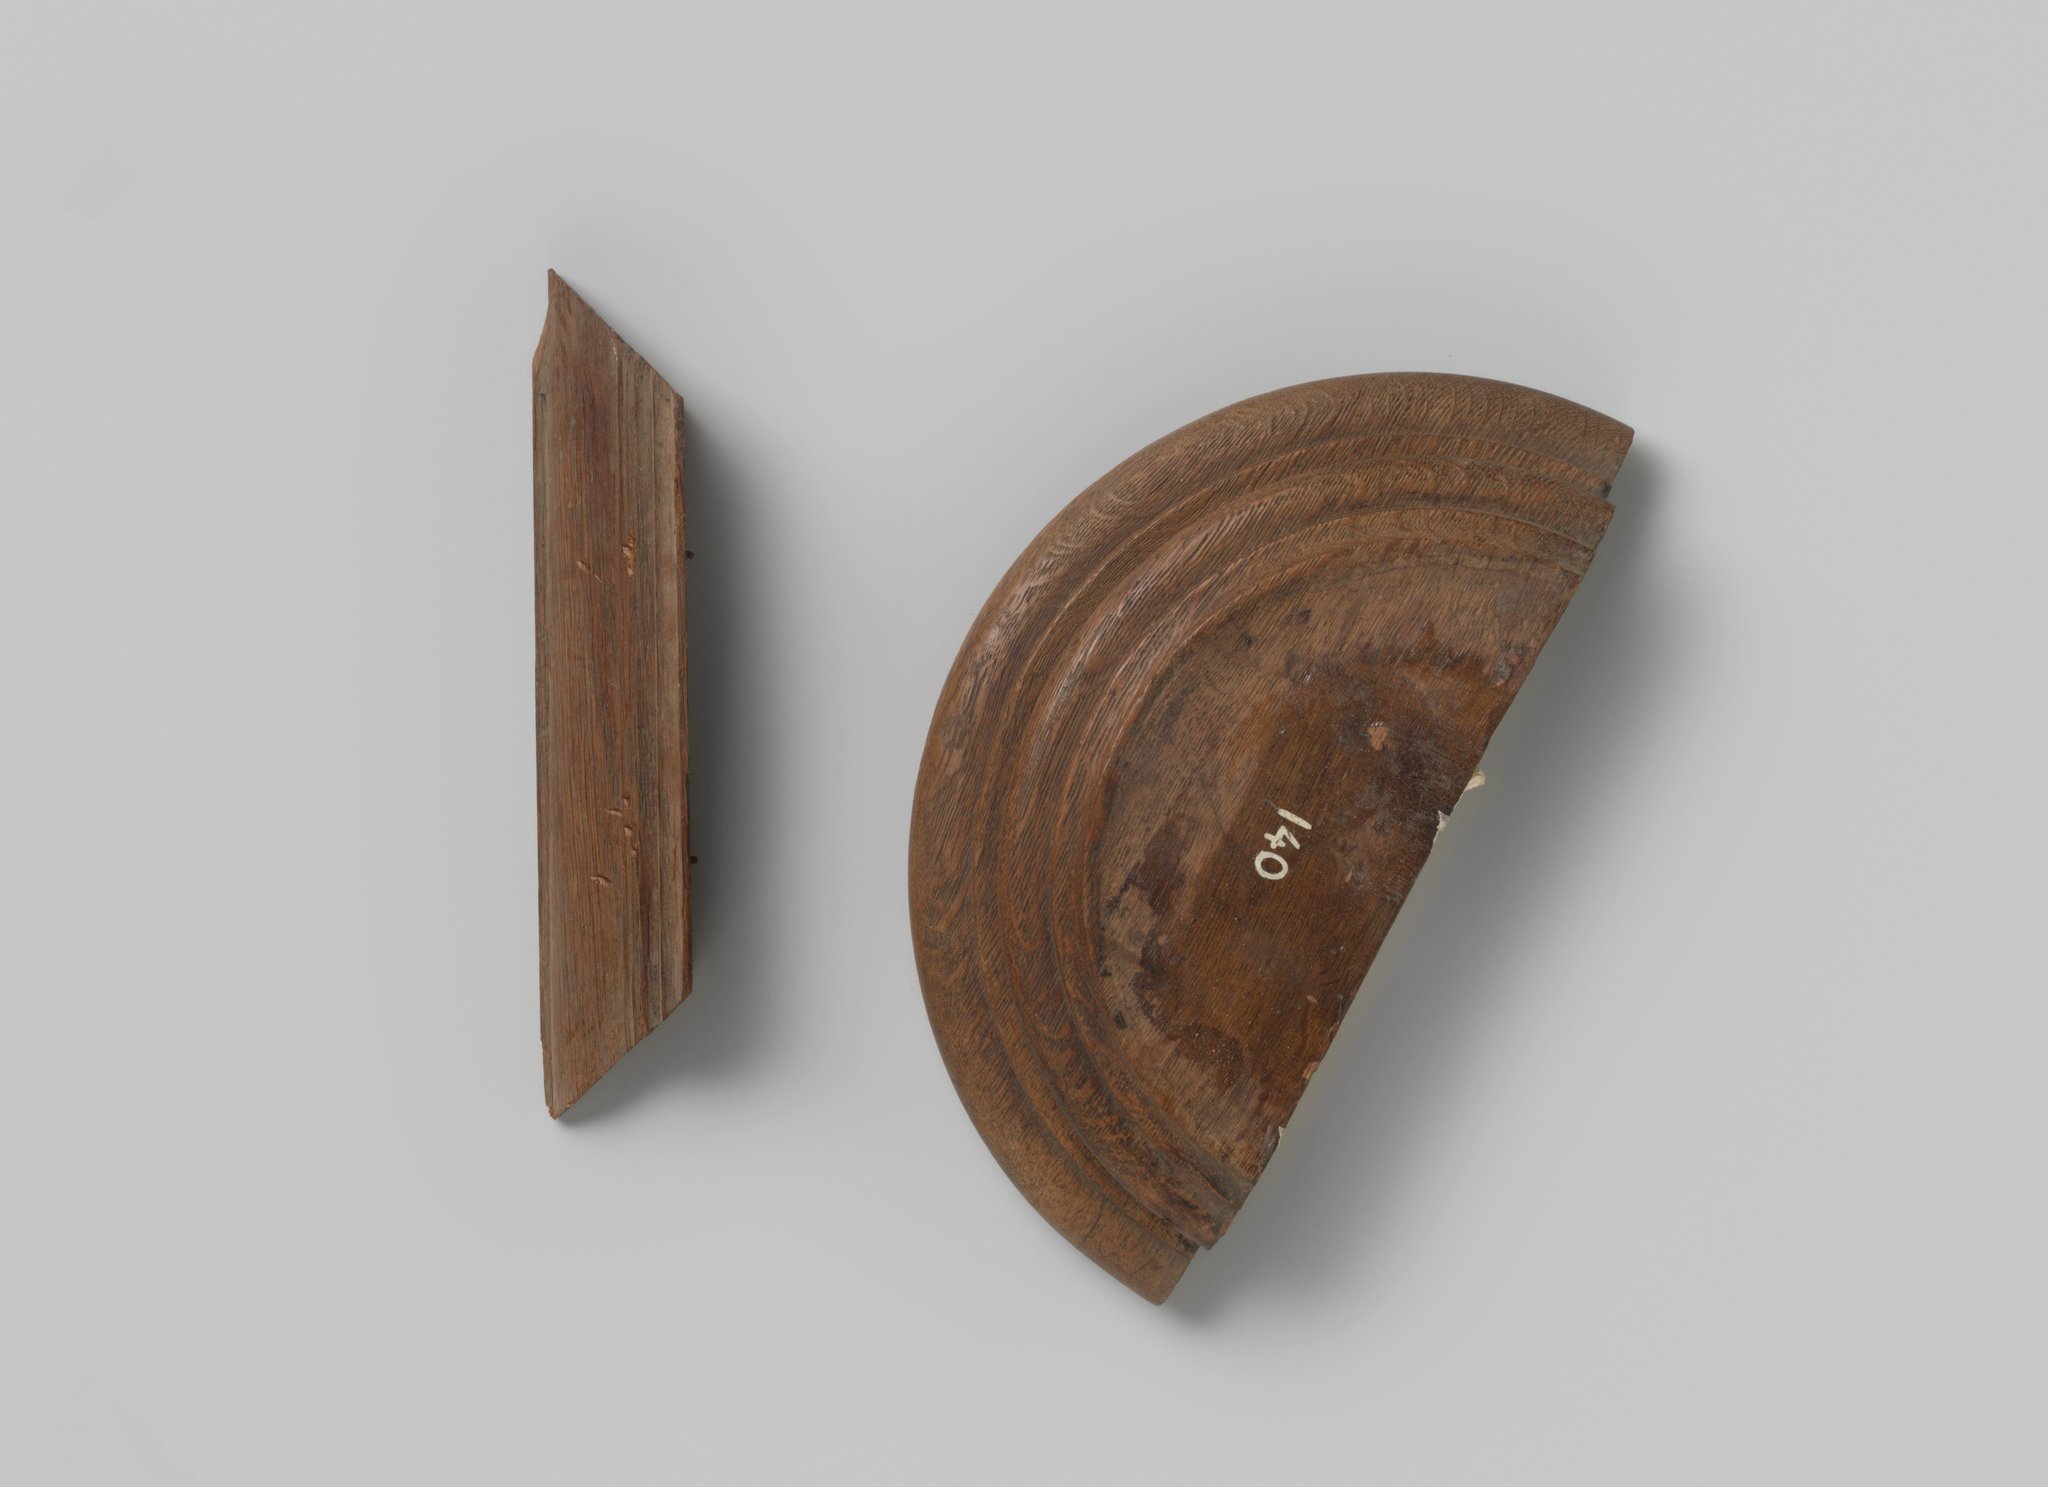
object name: furniture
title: Fragmenten van een bedstede afkomstig uit "het huis van Alva", Warmoesstraat Amsterdam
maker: Anonymous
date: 1600-1650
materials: wood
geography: northern netherlands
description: Drie fragmenten behorend bij een bedstede. Een halfrond geprofileerd onderdeel waar140 op staat geschreven, een rechthoekige plank en een fragment van een lambrisering.